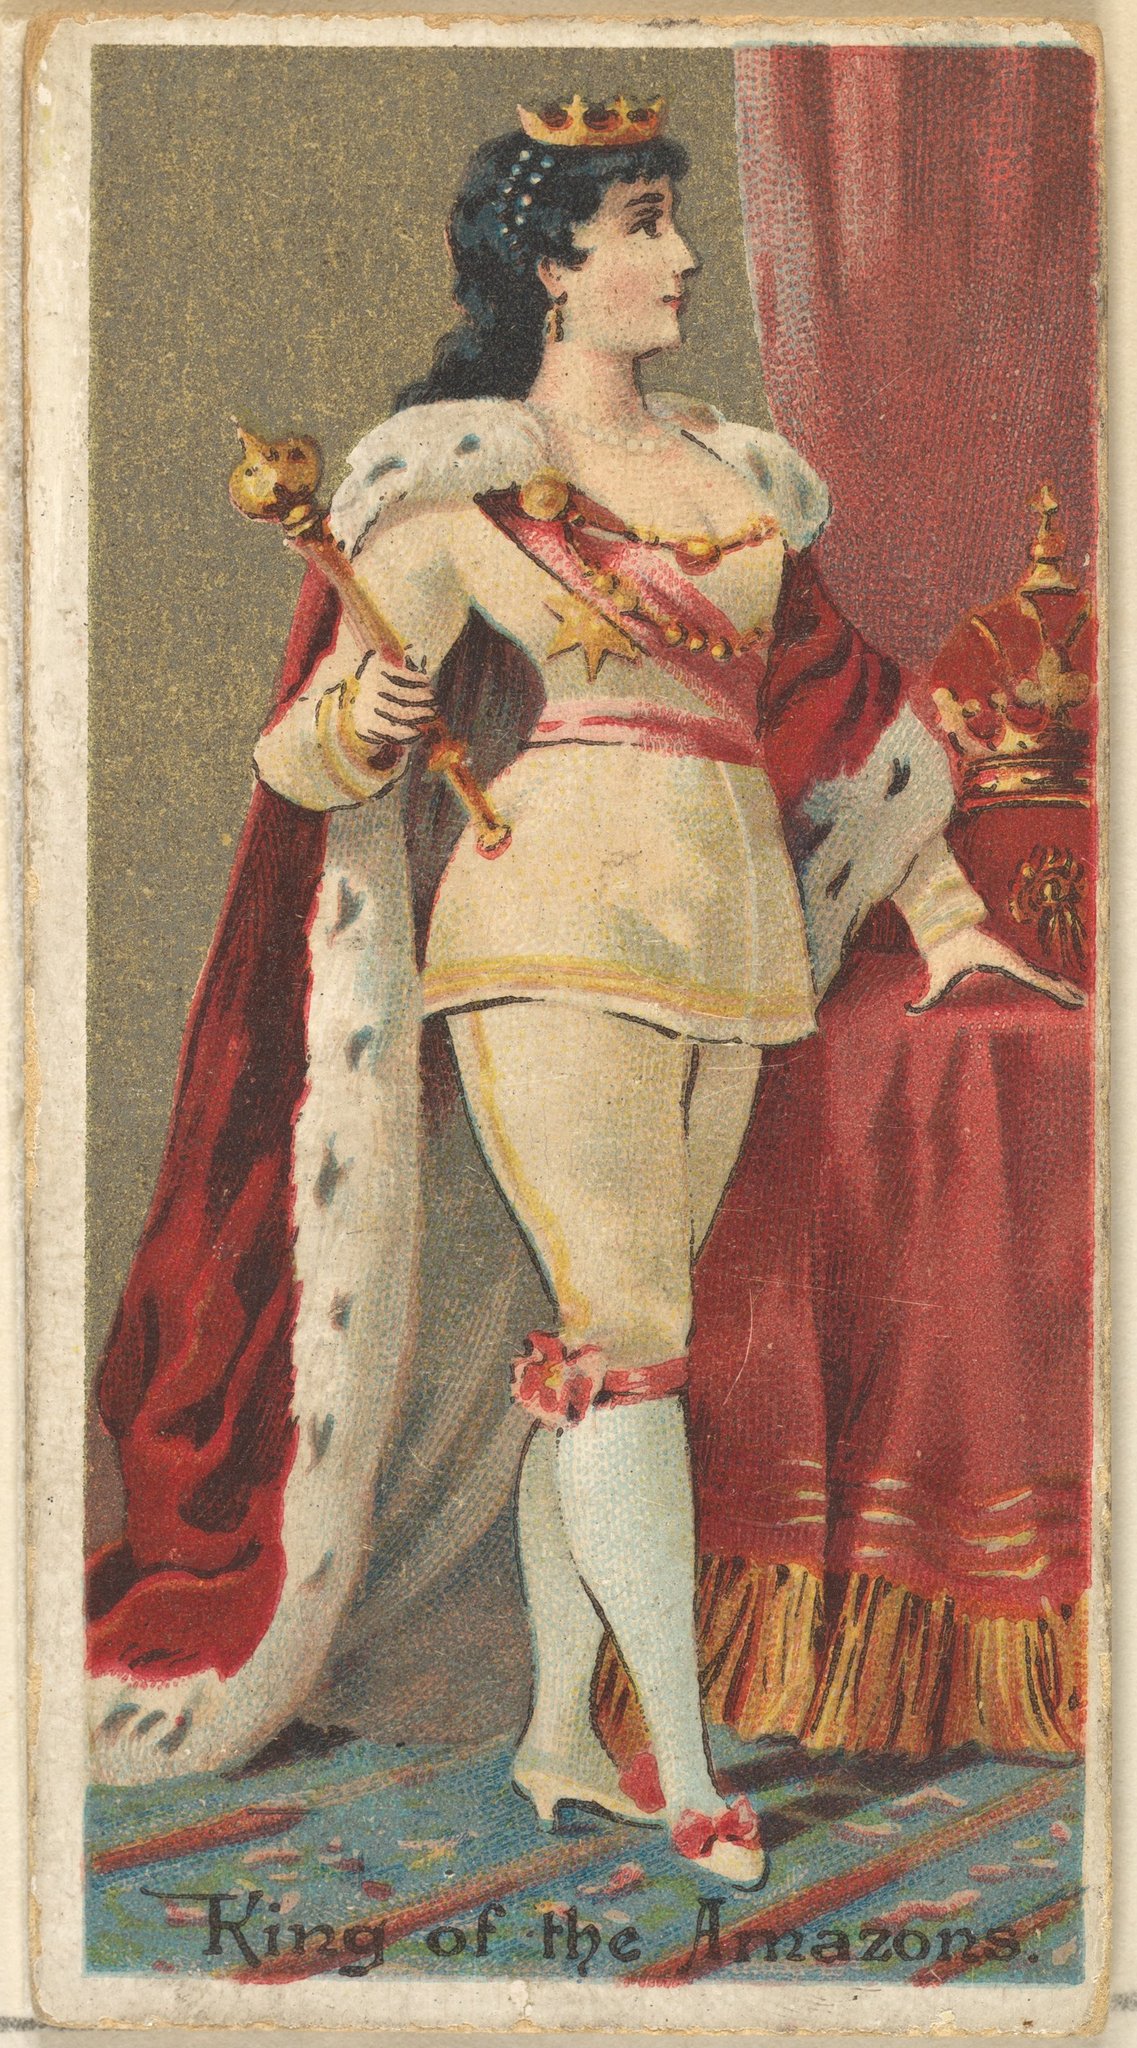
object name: print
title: King of the Amazons, from the Occupations for Women series (N166) for Old Judge and Dogs Head Cigarettes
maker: goodwin & company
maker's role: publisher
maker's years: 1850-1950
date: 1887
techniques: color lithograph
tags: women